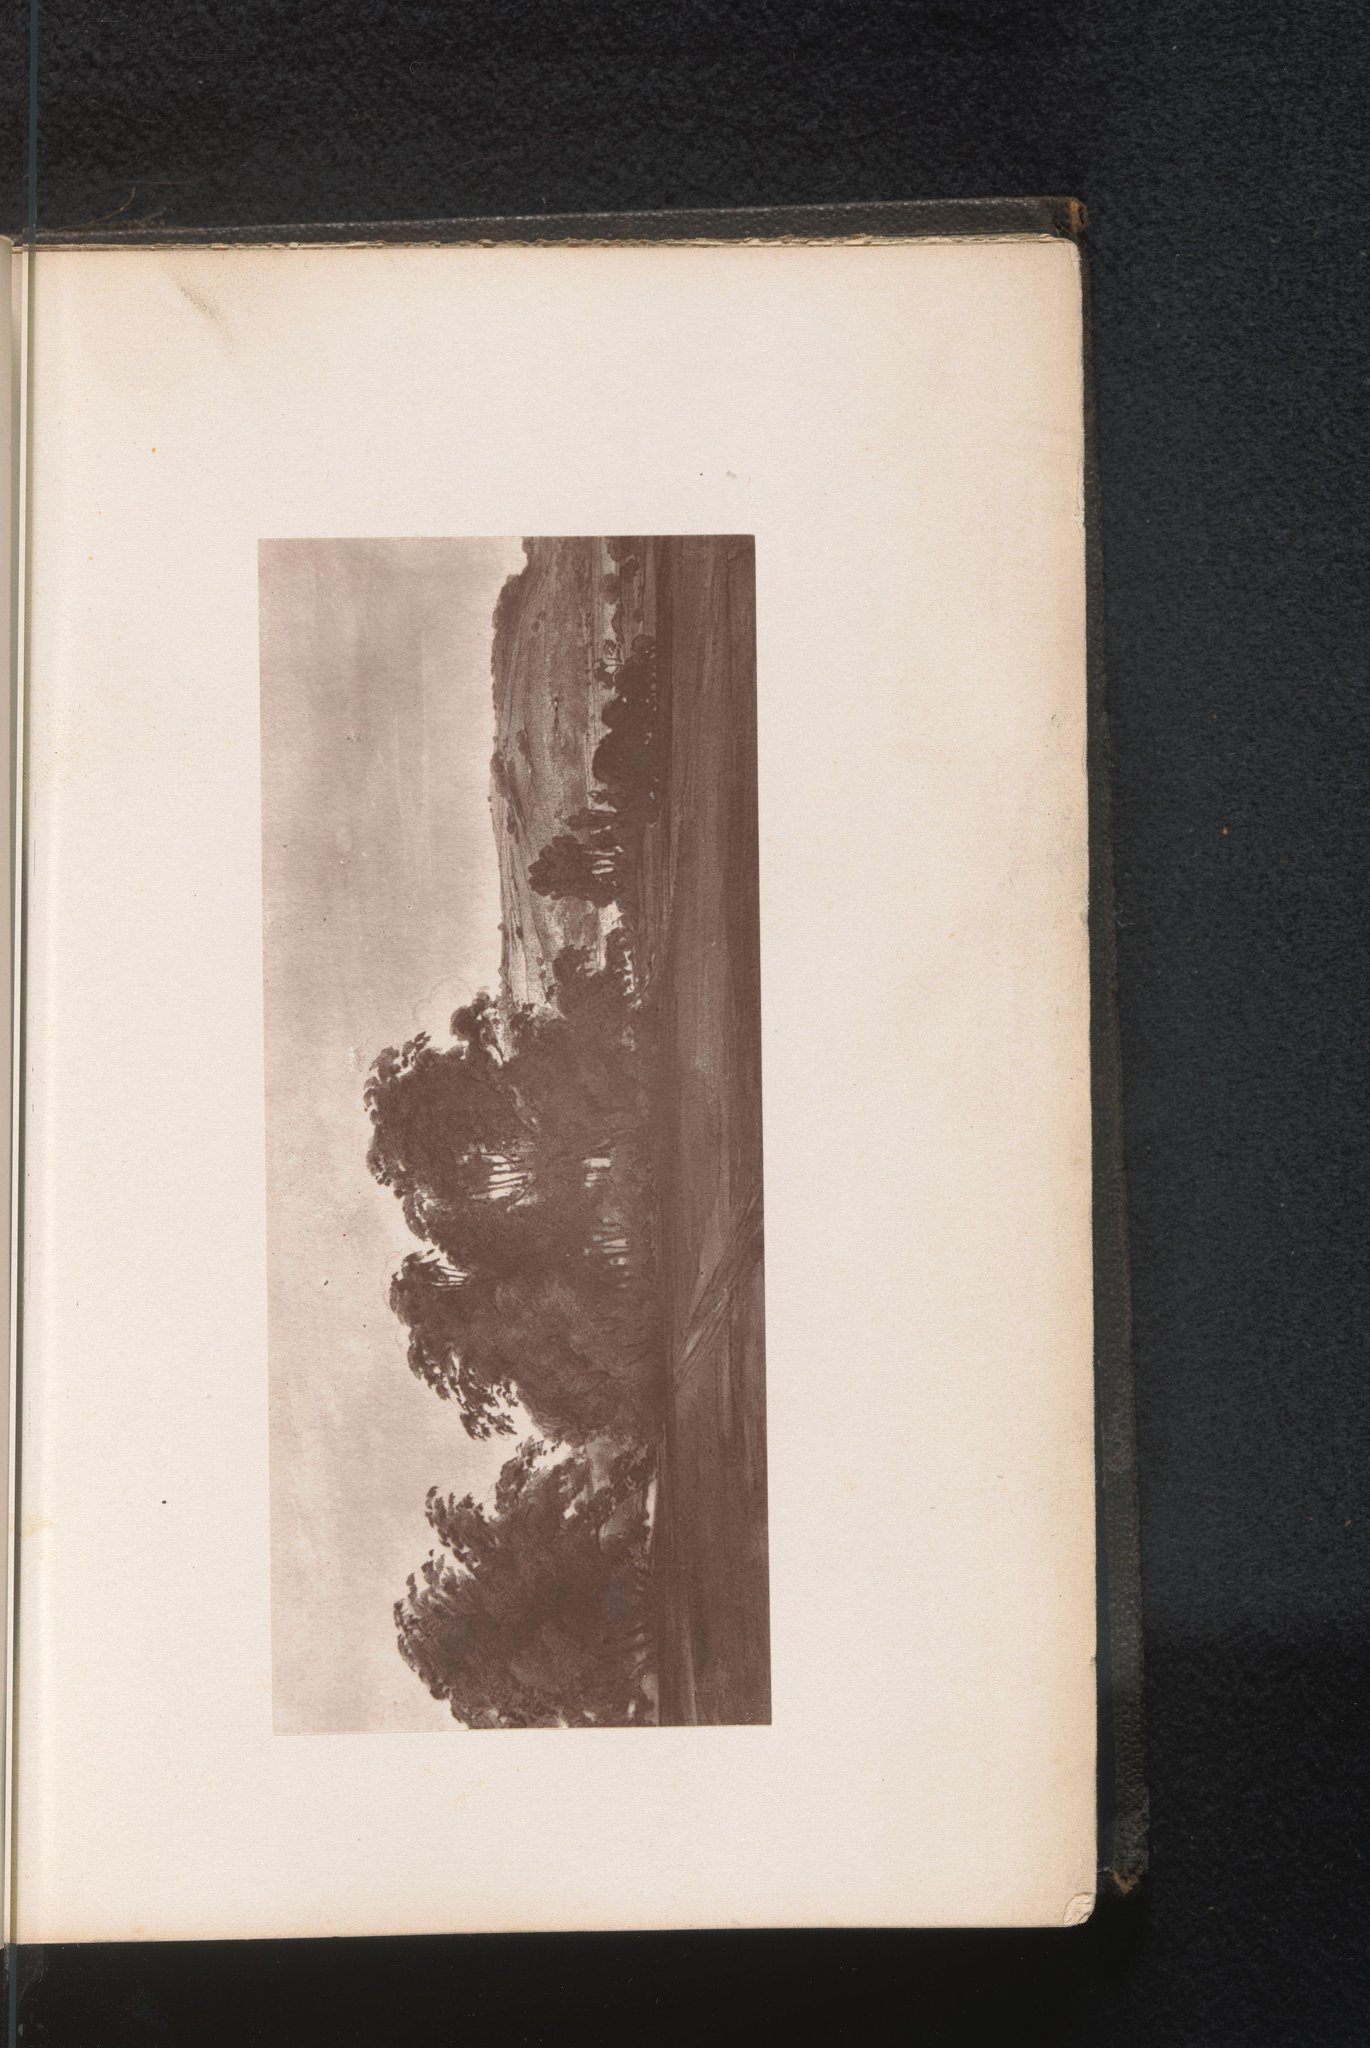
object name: page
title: Fotoreproductie van een schildering, voorstellende een gezicht op wilgen te Stoke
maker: Anonymous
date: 1866-1876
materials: paper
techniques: woodburytype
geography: stoke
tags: low hill country, trees: willow